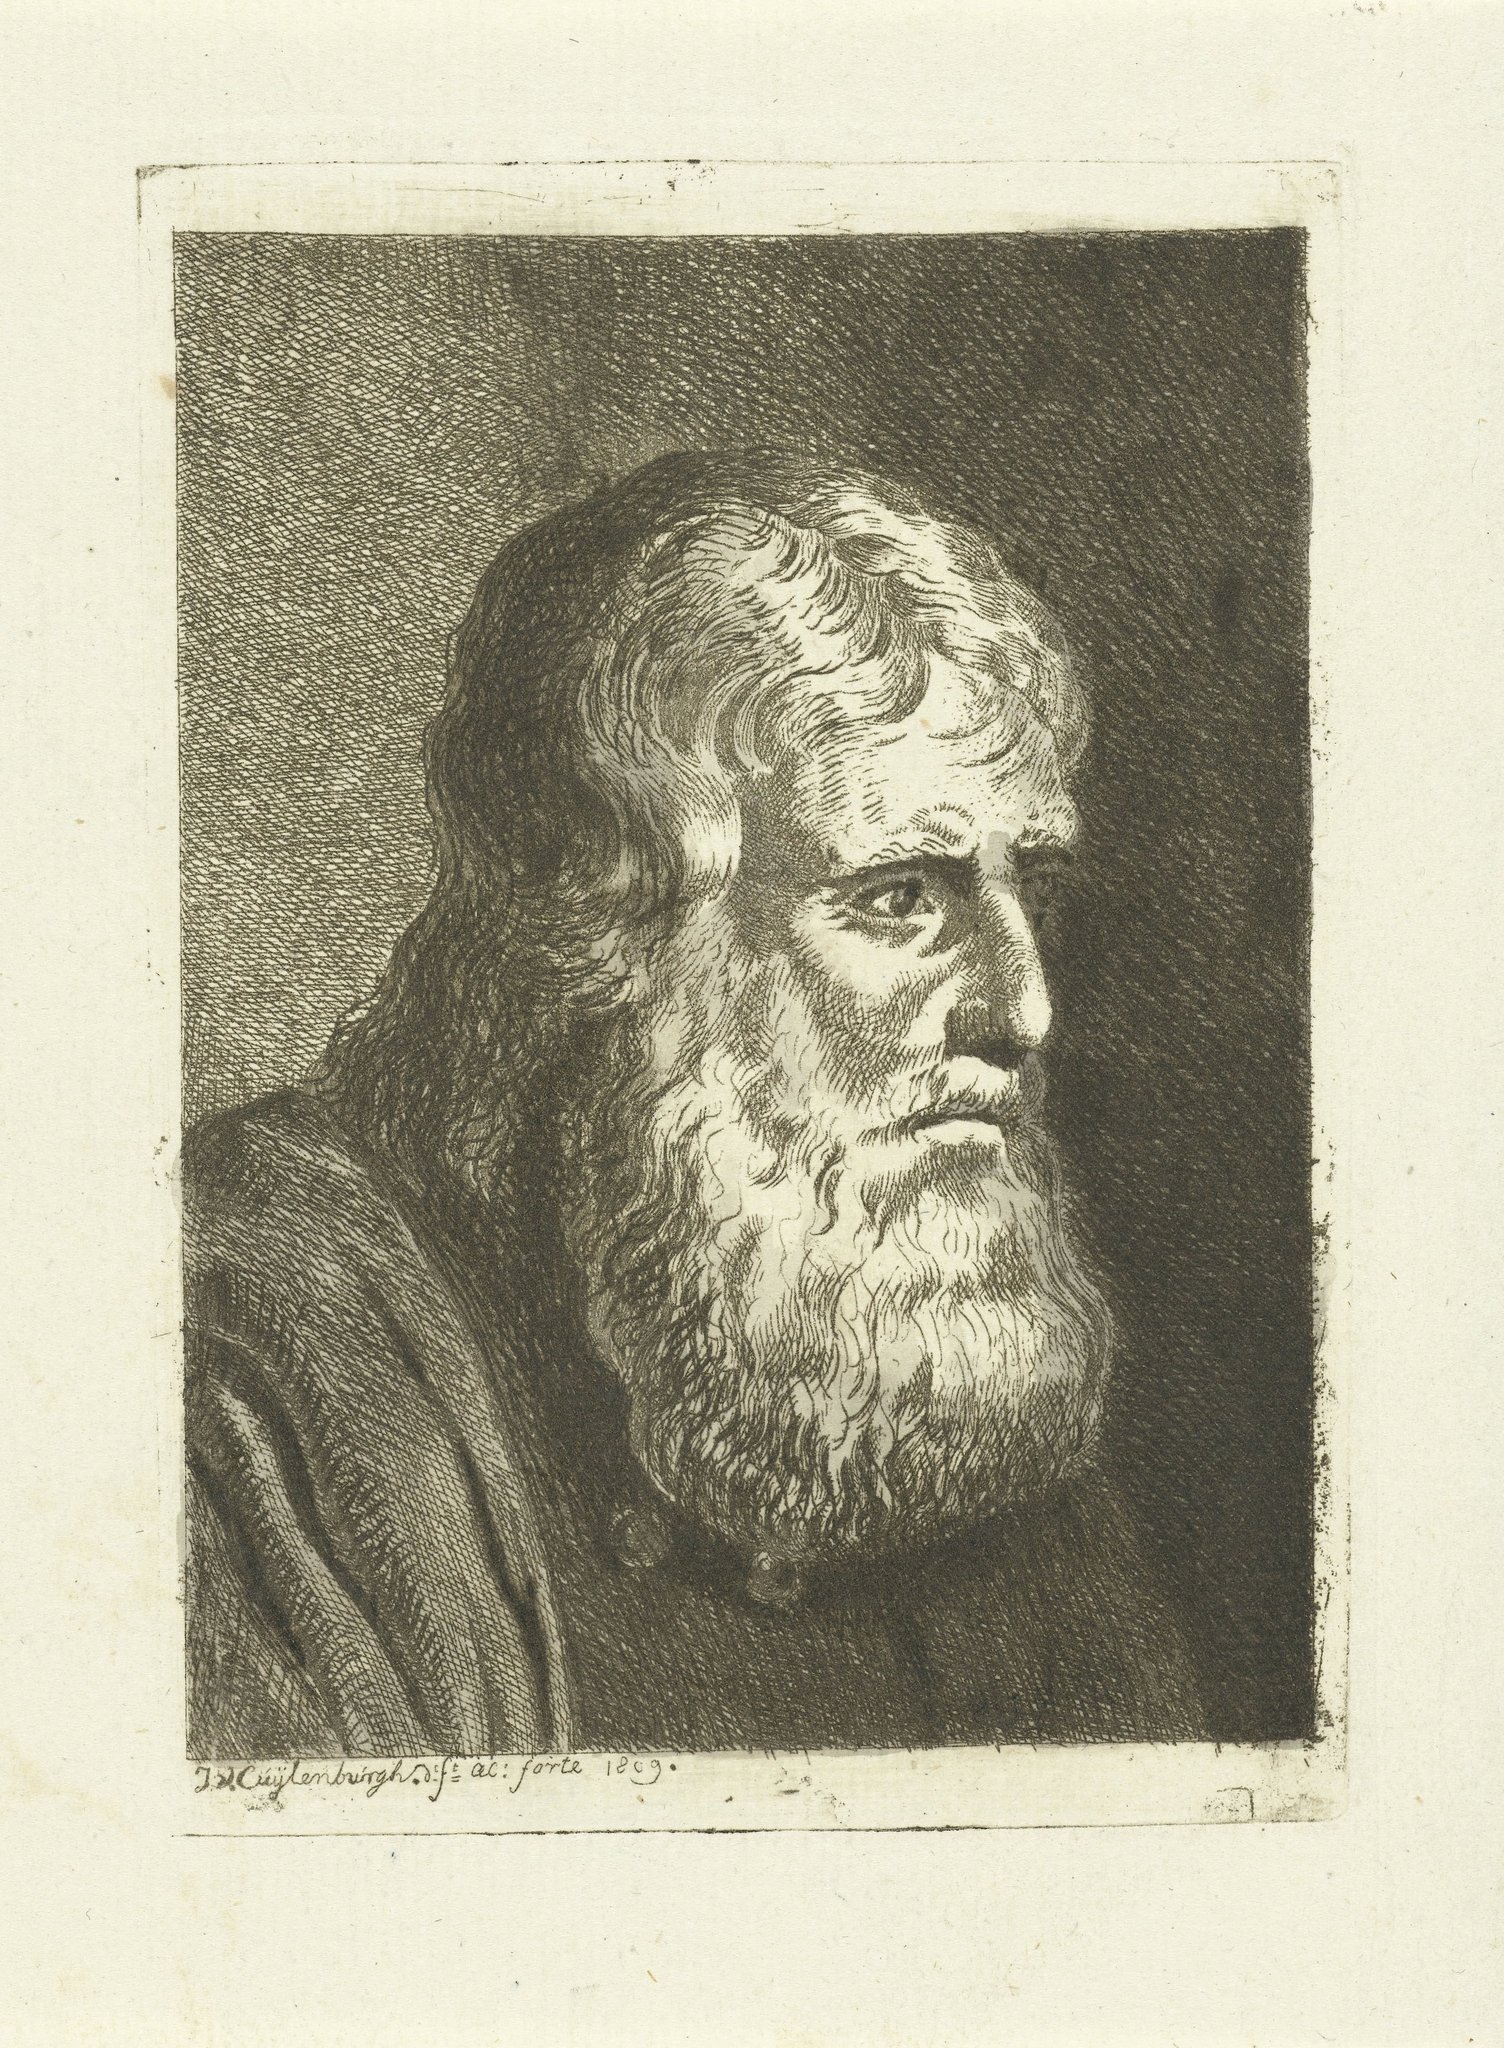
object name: print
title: Portret van man met baard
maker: johannes van cuylenburgh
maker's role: print maker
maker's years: 1793-1841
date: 1809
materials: paper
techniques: etching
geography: netherlands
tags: beard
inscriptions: collector's mark: Lugt 2228